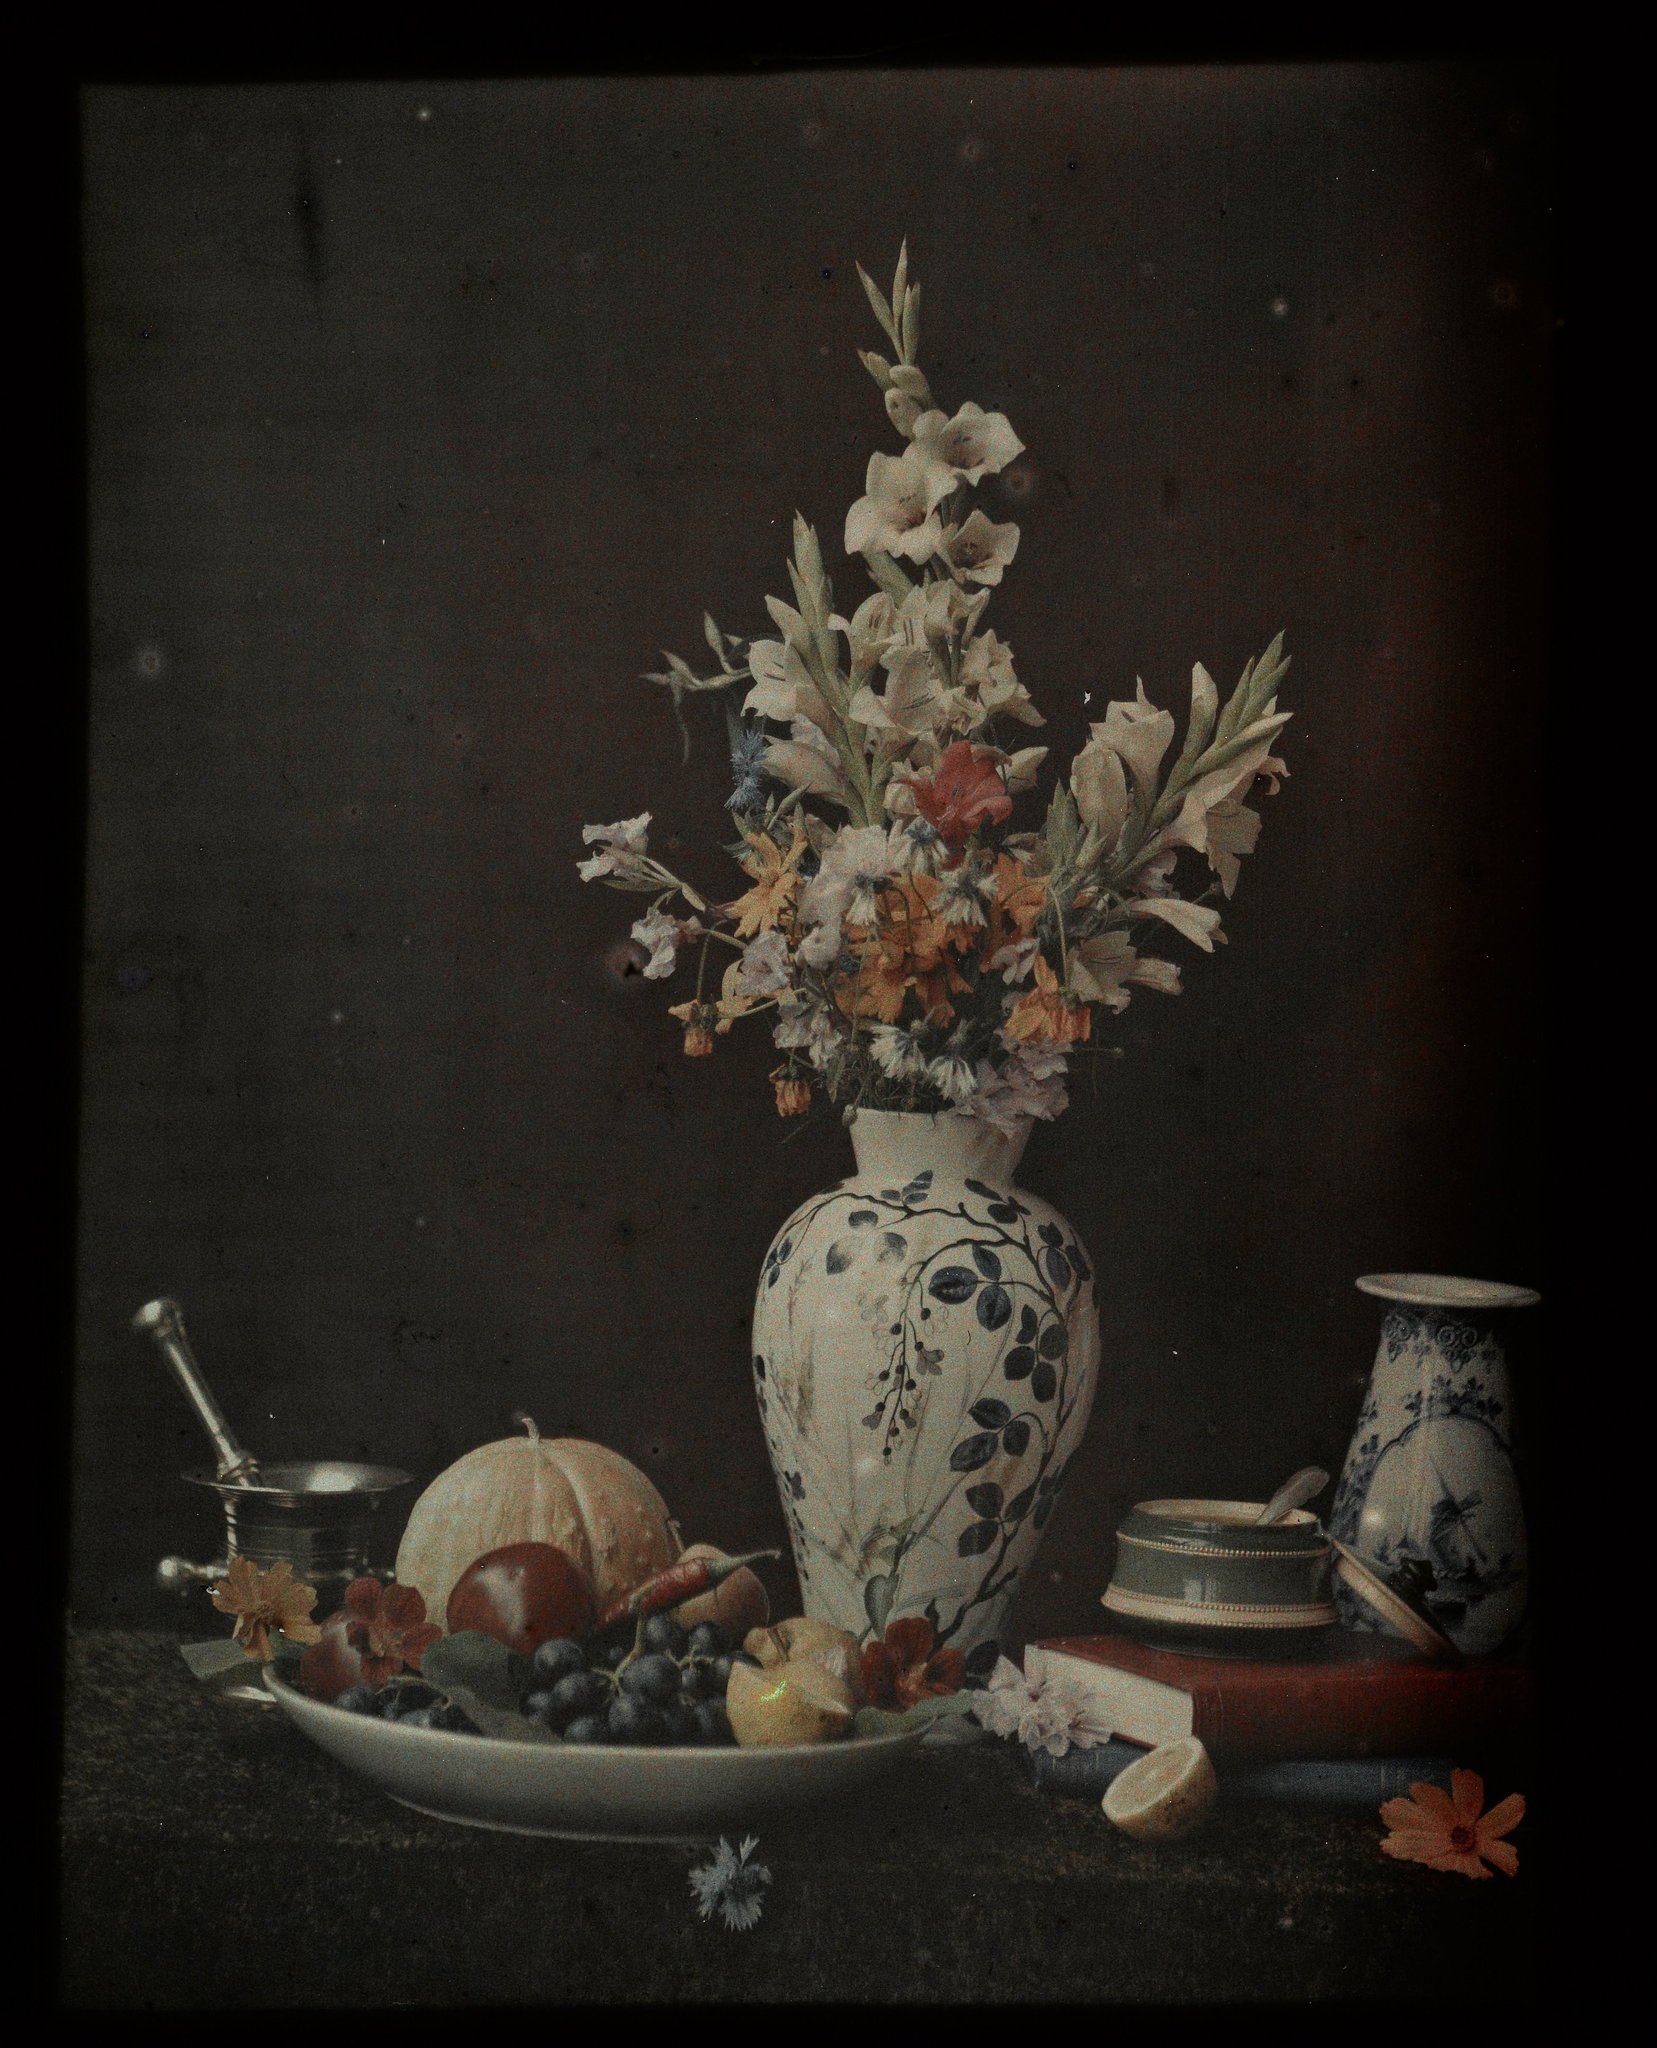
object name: color slide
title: Stilleven met bloemen, fruit en vazen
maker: Anonymous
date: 1907-1930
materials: glass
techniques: autochrome process, slide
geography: netherlands